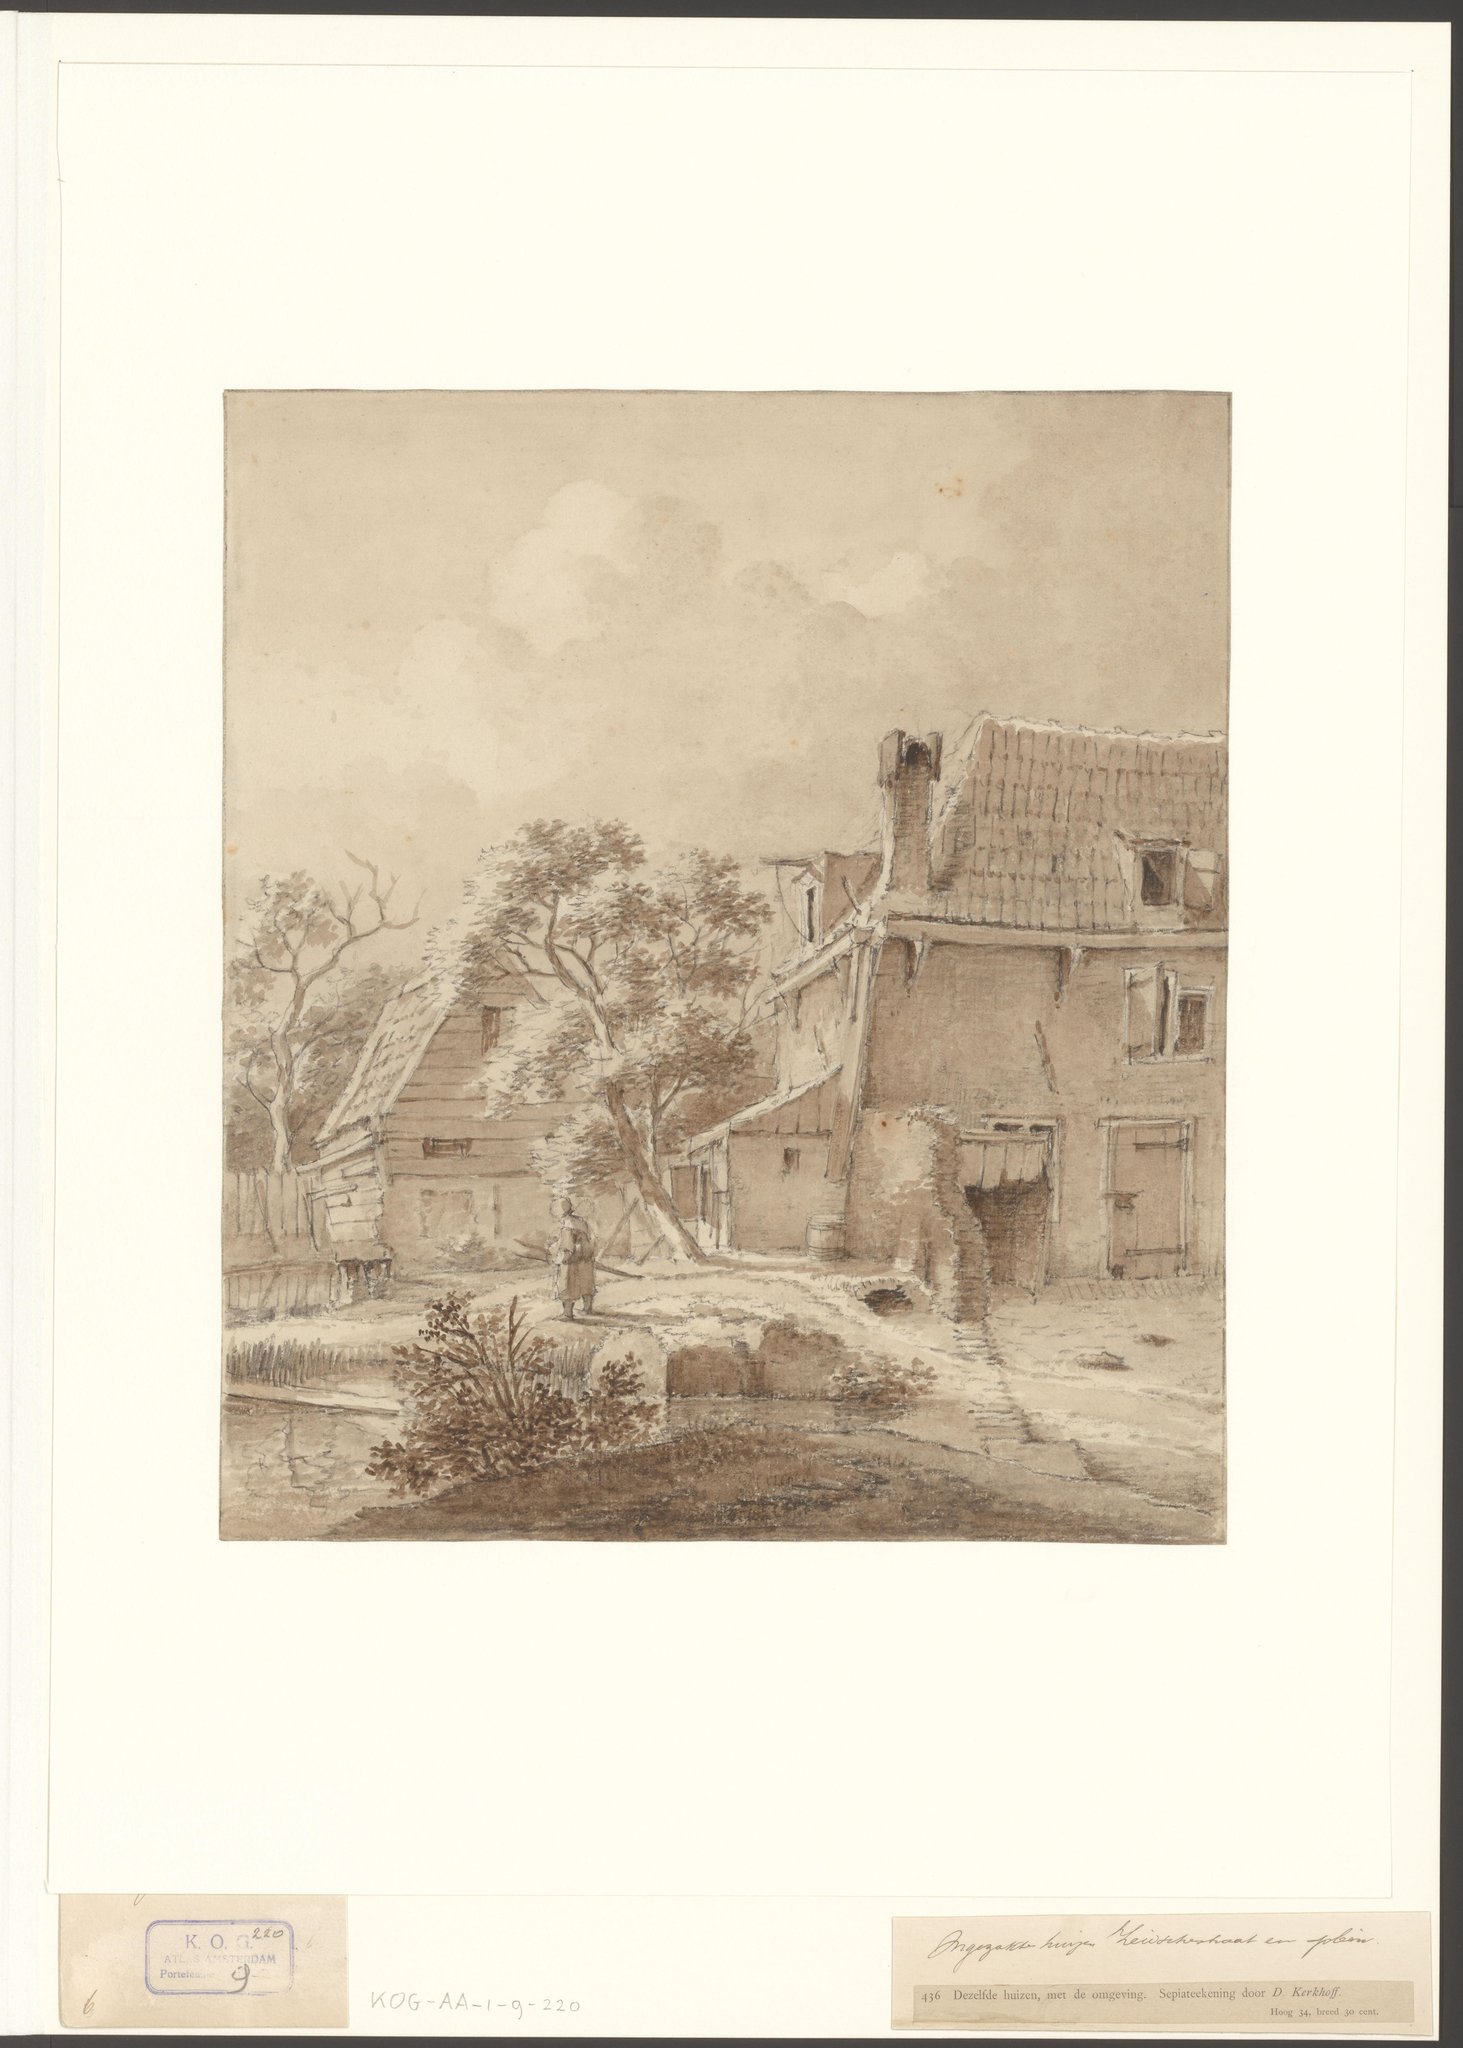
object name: drawing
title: Gezicht op enkele ingestorte huizen op de hoek van het Leidseplein en de Leidsestraat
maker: daniël kerkhoff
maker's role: draughtsman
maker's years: 1766-1821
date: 1806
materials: chalk, ink, paper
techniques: brush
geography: amsterdam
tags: city-view in general; 'veduta', collapsing building, the usual house or row of houses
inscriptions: inscription: ‘Ingezakte huizen Leidschestraat (...) breed 30 cent.’, inscription: ‘Port. 9 - 220 (...) plijn - D. Kerkhoff’, inscription: ‘Geschenk van den Heer / J.F.M. Sterck’, collector's mark: ‘9’ Lugt 1641b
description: Onderwerpsrubriek binnen de Atlas Amsterdam: 2e Laurierdwarsstraat (Vuile Weespad), Leidschegracht, Leidschekade, Leidscheplein, Leidschestraat, v. Lennepkade, Lijnbaansgracht, Lauriergracht, Leliedwarsstraat, Leliegracht, Lindengracht, Lombardsteeg, Looiersgracht, Looiersstraat (Nieuwe), Leidekkerssteeg.